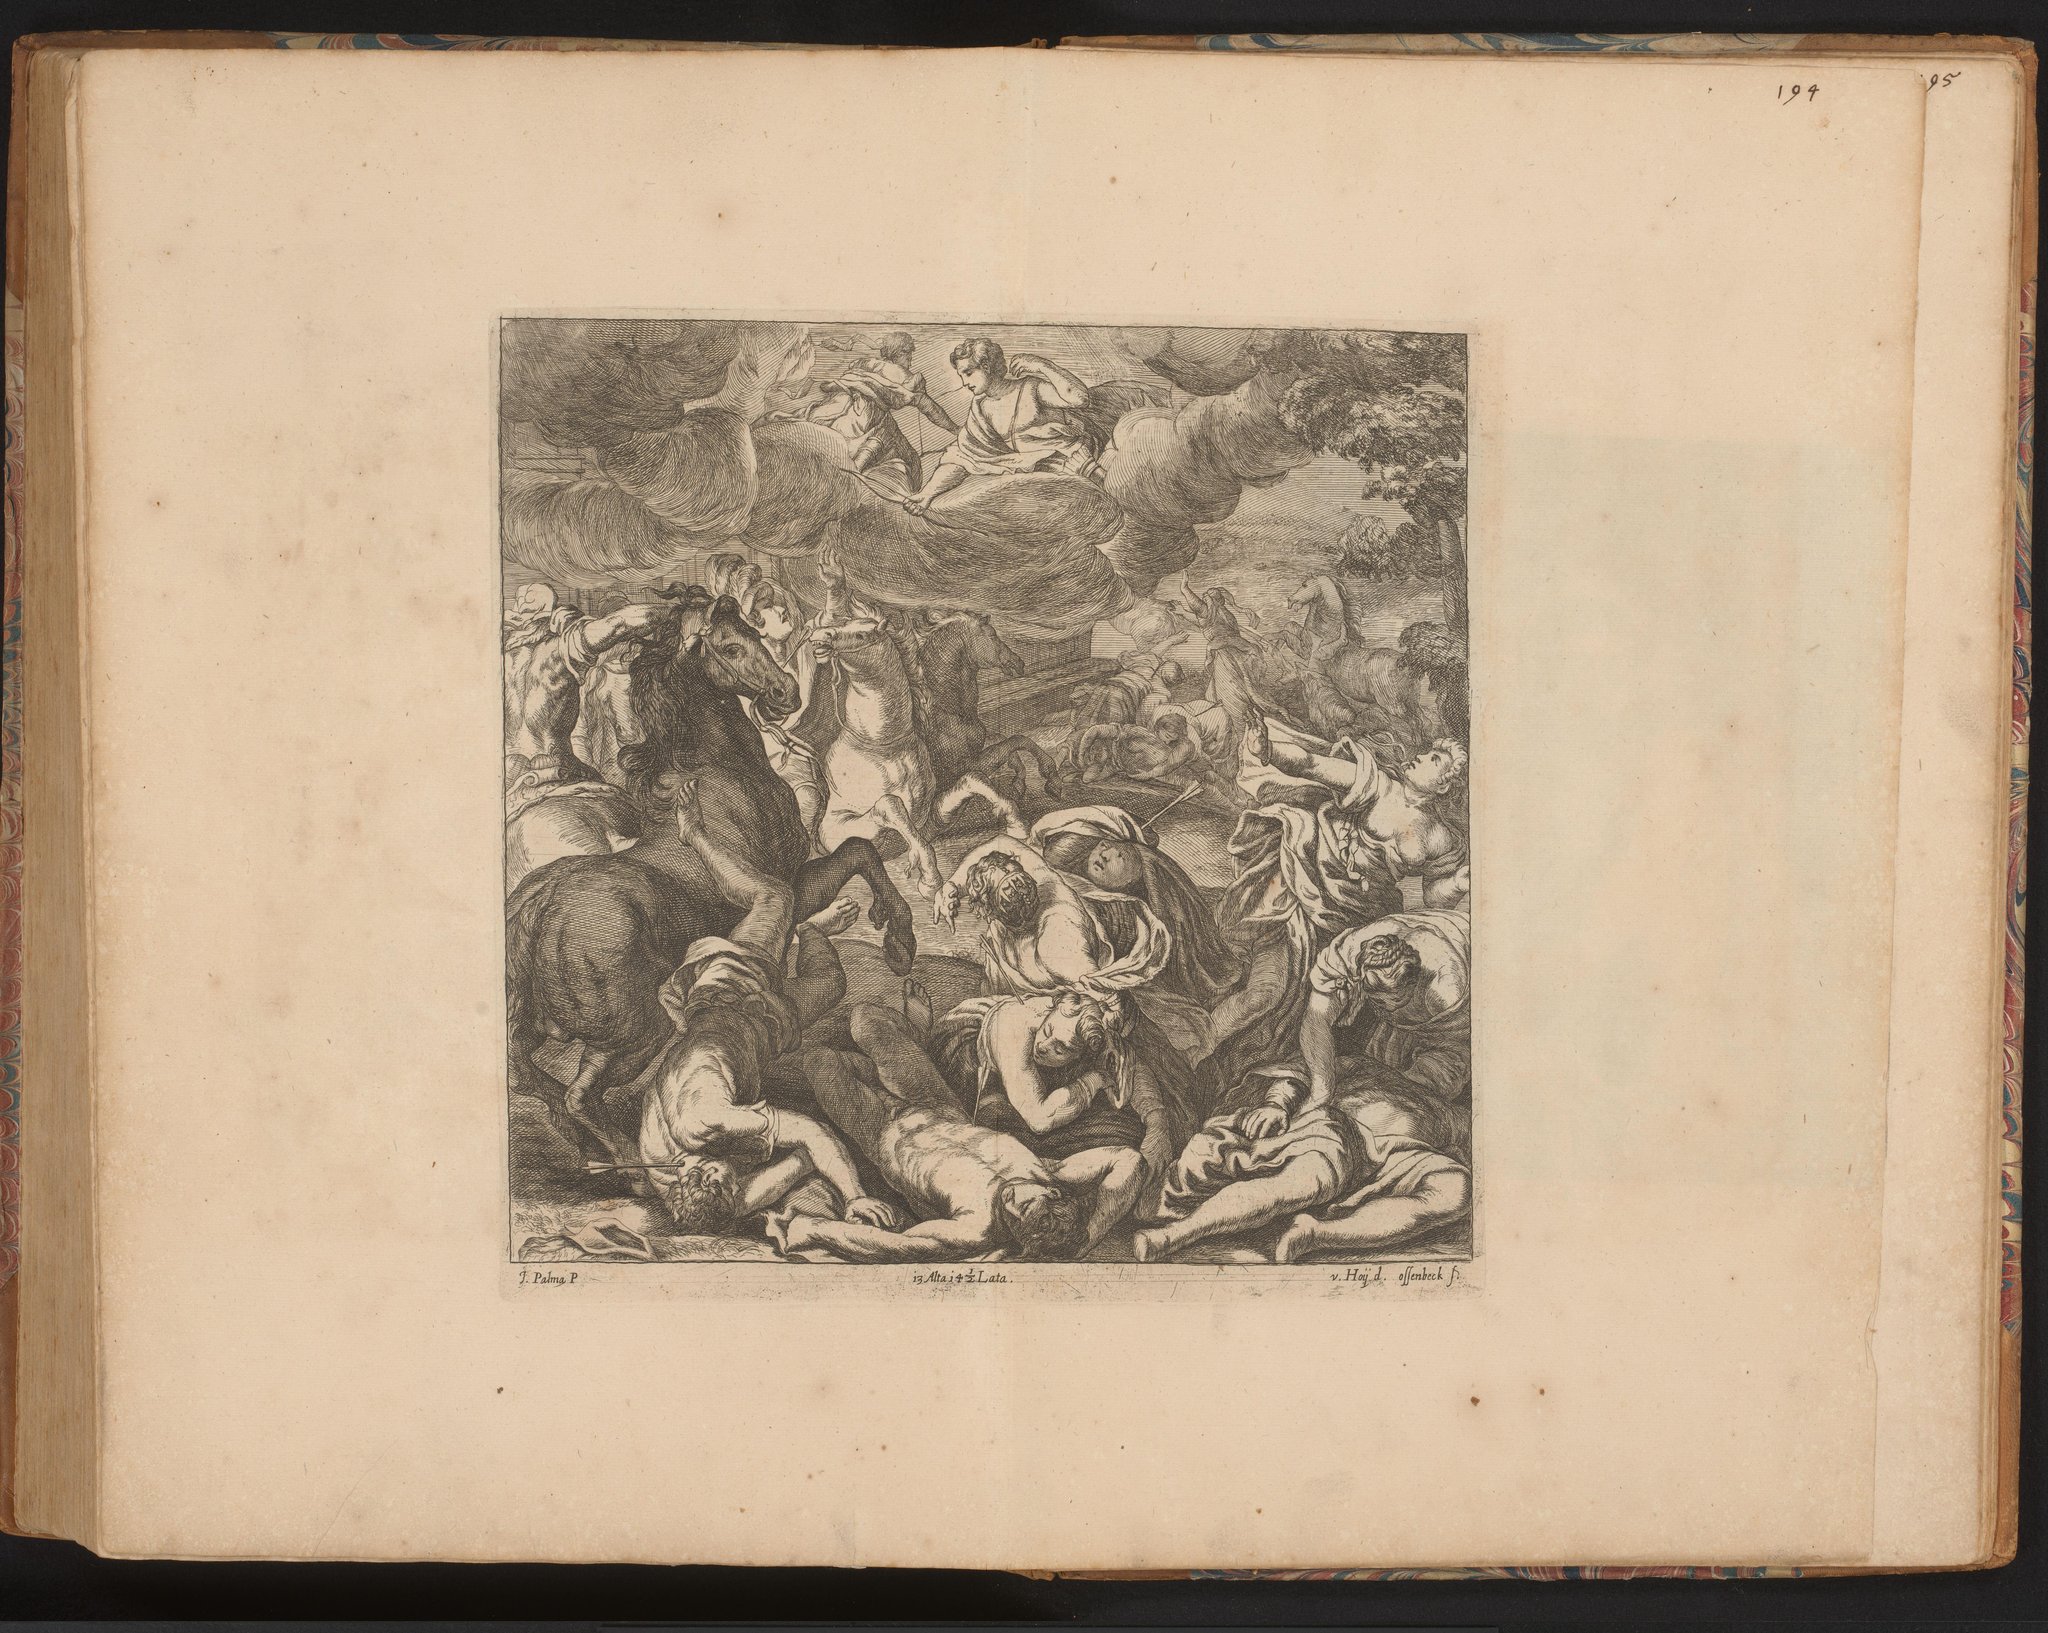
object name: print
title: Apollo en Diana doden de kinderen van Niobe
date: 1660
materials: paper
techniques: etching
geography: vienna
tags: apollo and diana kill niobe's children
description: De prent is vervaardigd naar een schilderij, toegeschreven aan Michieli, dat zich in de Praagse burcht bevindt. David Teniers heeft waarschijnlijk van alle schilderijen uit de collectie van Leopold Willem van Oostenrijk een olieverfstudie op doek of paneel vervaardigd (zgn. pasticcio), die als voorbeeld voor de prentmakers diende. Het is niet altijd duidelijk of de pasticci door hem zijn gemaakt of door zijn atelier. Niet alle pasticci zijn overgeleverd.